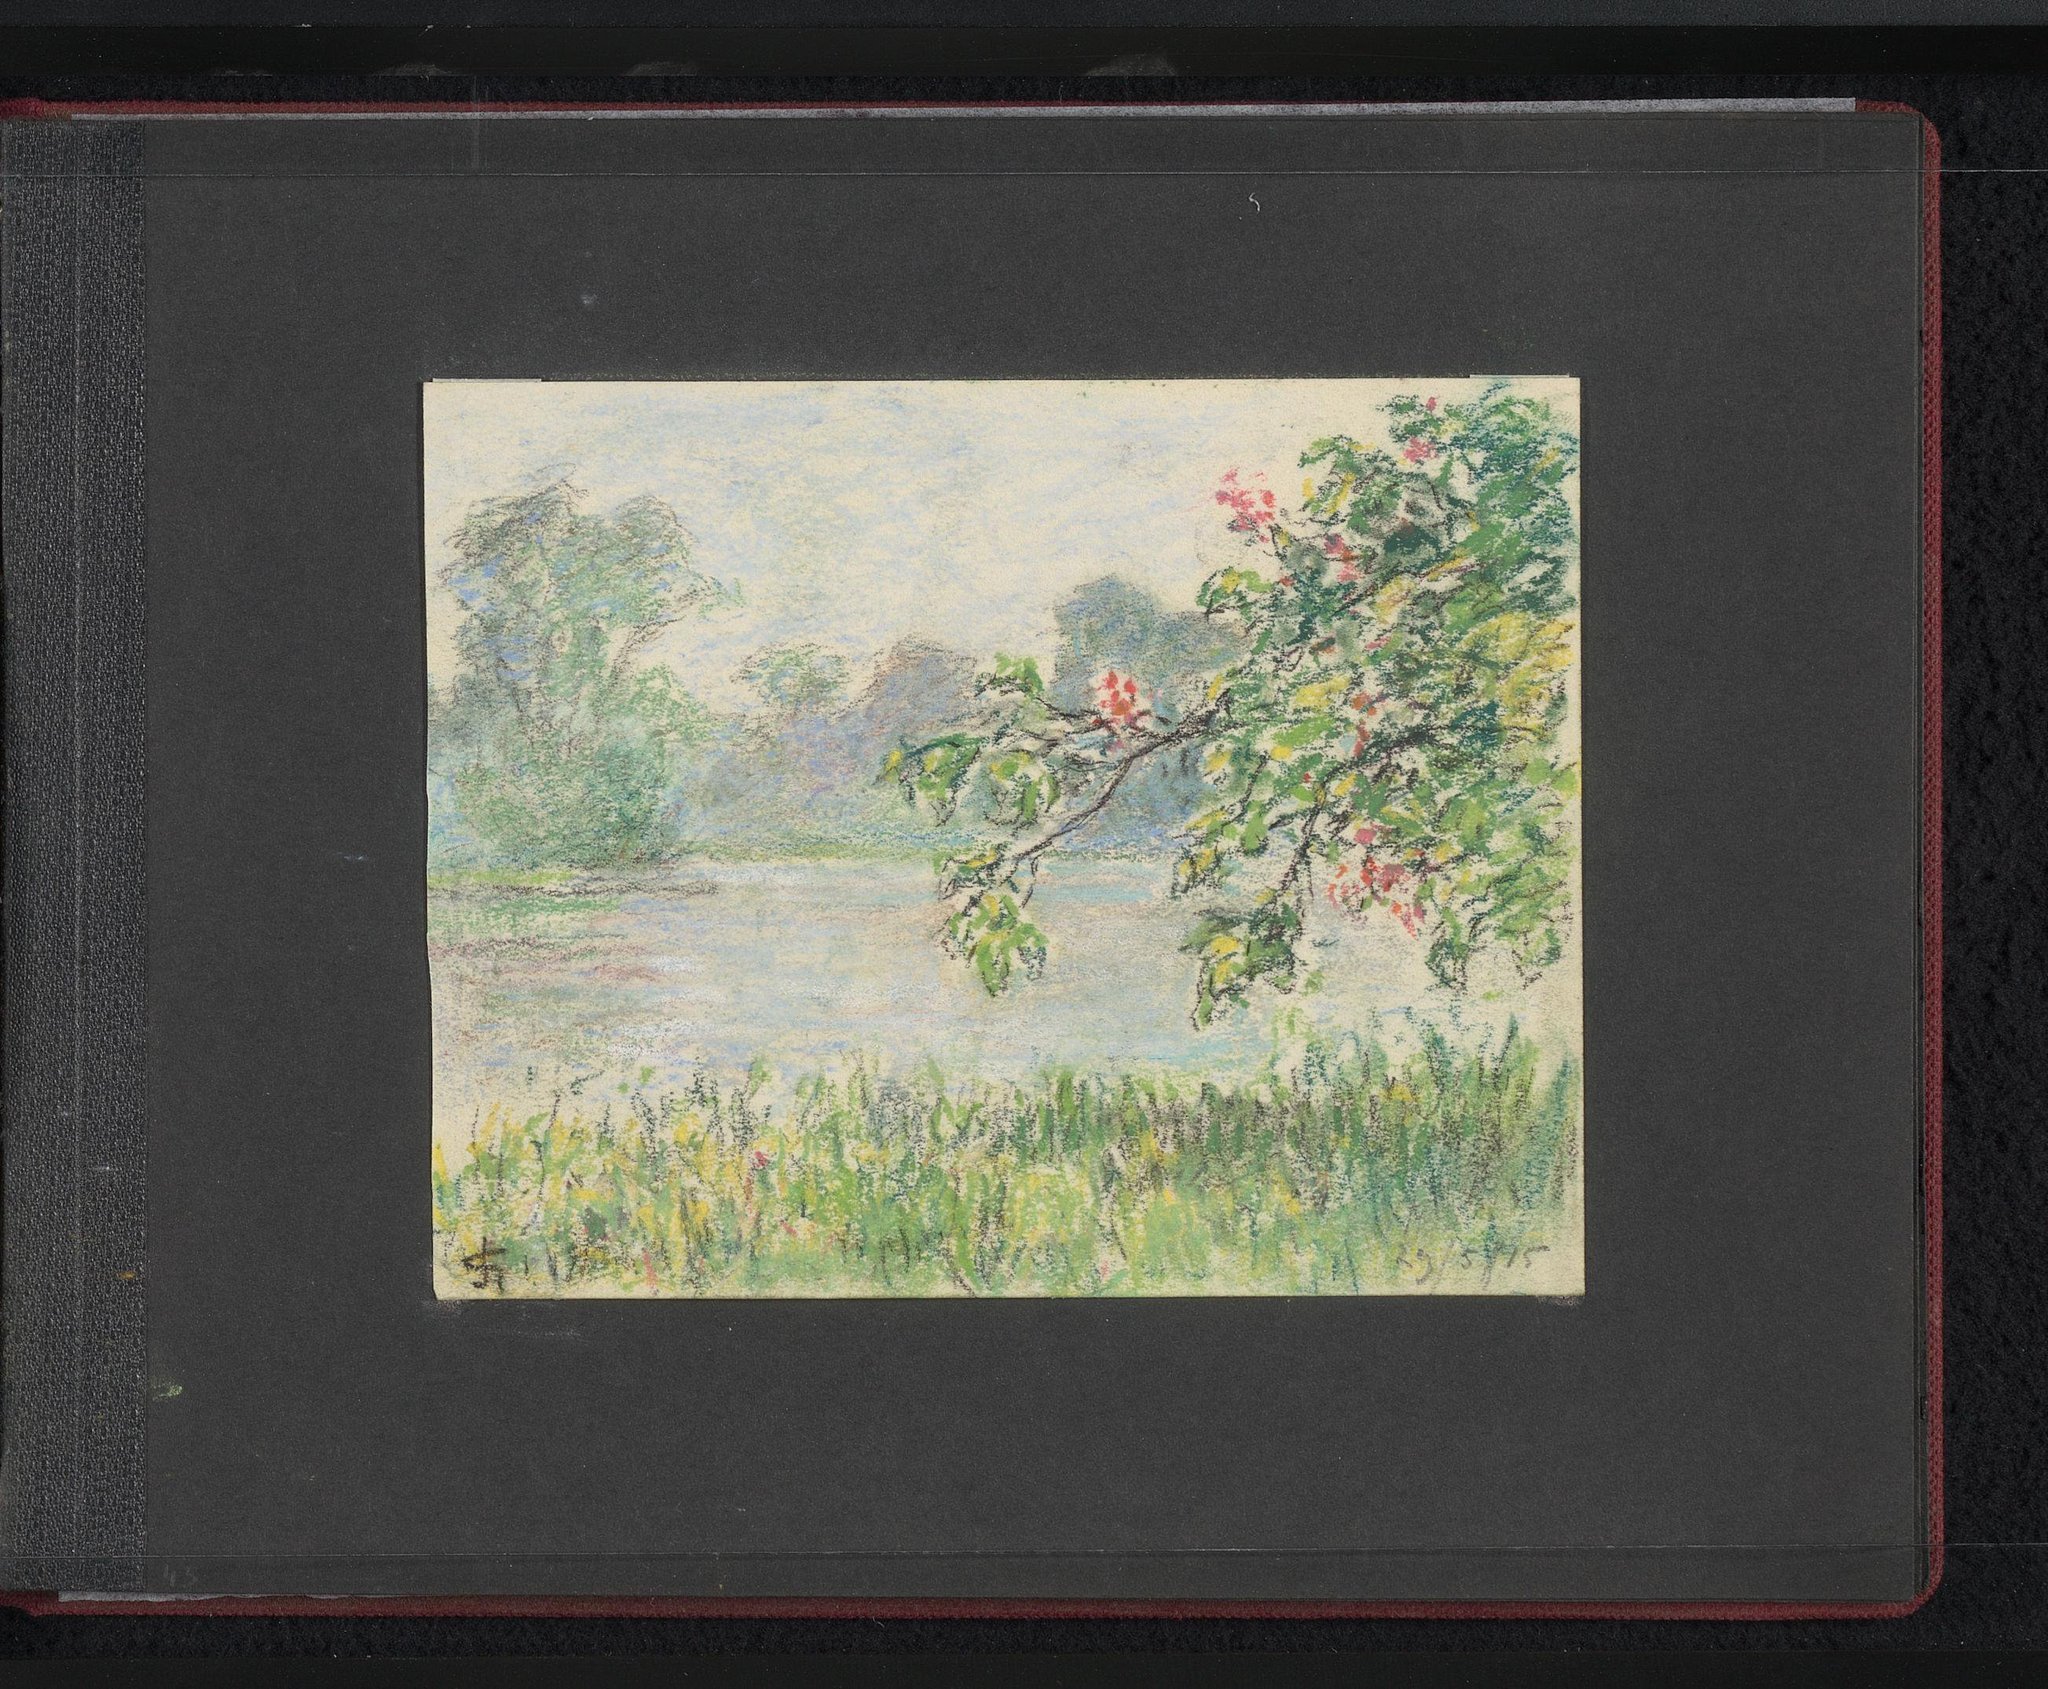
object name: drawing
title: Bloeiende takken voor een vijver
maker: carel nicolaas storm van s-gravesande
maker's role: draughtsman, print maker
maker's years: 1841-1924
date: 1915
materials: chalk, paper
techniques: pasting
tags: flowers, park, trees, garden pond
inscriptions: date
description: Mogelijk in het park van Slot Biebrich te Wiesbaden. Tekening maakt deel uit van een album.